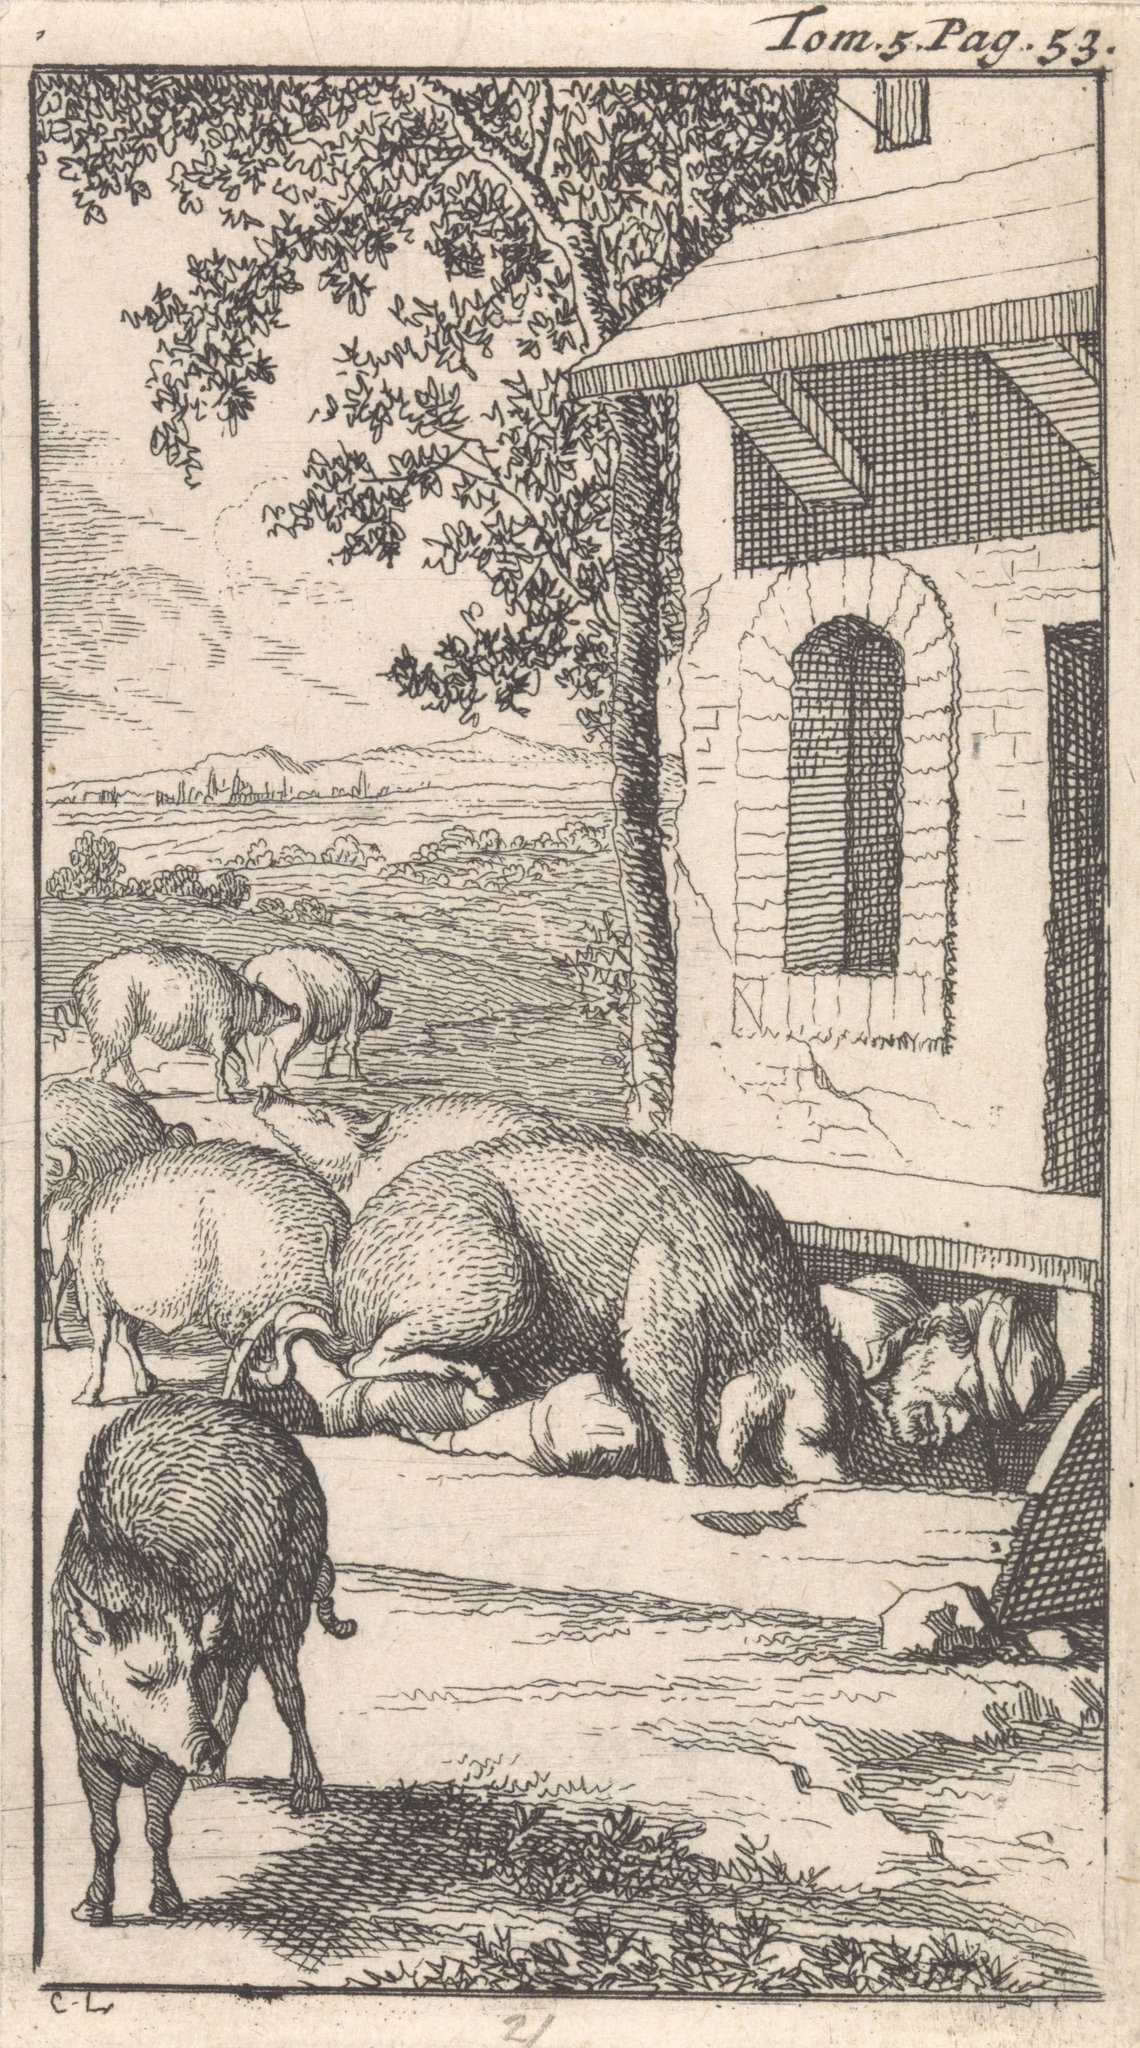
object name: print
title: Sancho slapend in een varkenstrog voor een boerderij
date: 1696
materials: paper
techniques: etching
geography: amsterdam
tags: trough, sleeping; unconsciousness - bb - out of doors, sancho panza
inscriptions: number: ‘21’, collector's mark: Lugt 2228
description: Illustratie uit: Cervantes y Saavedra, Miguel de. Histoire de l'admirable Don Quixotte de La Manche, 5 delen. Amsterdam: Pieter Mortier, 1696, dl. V.